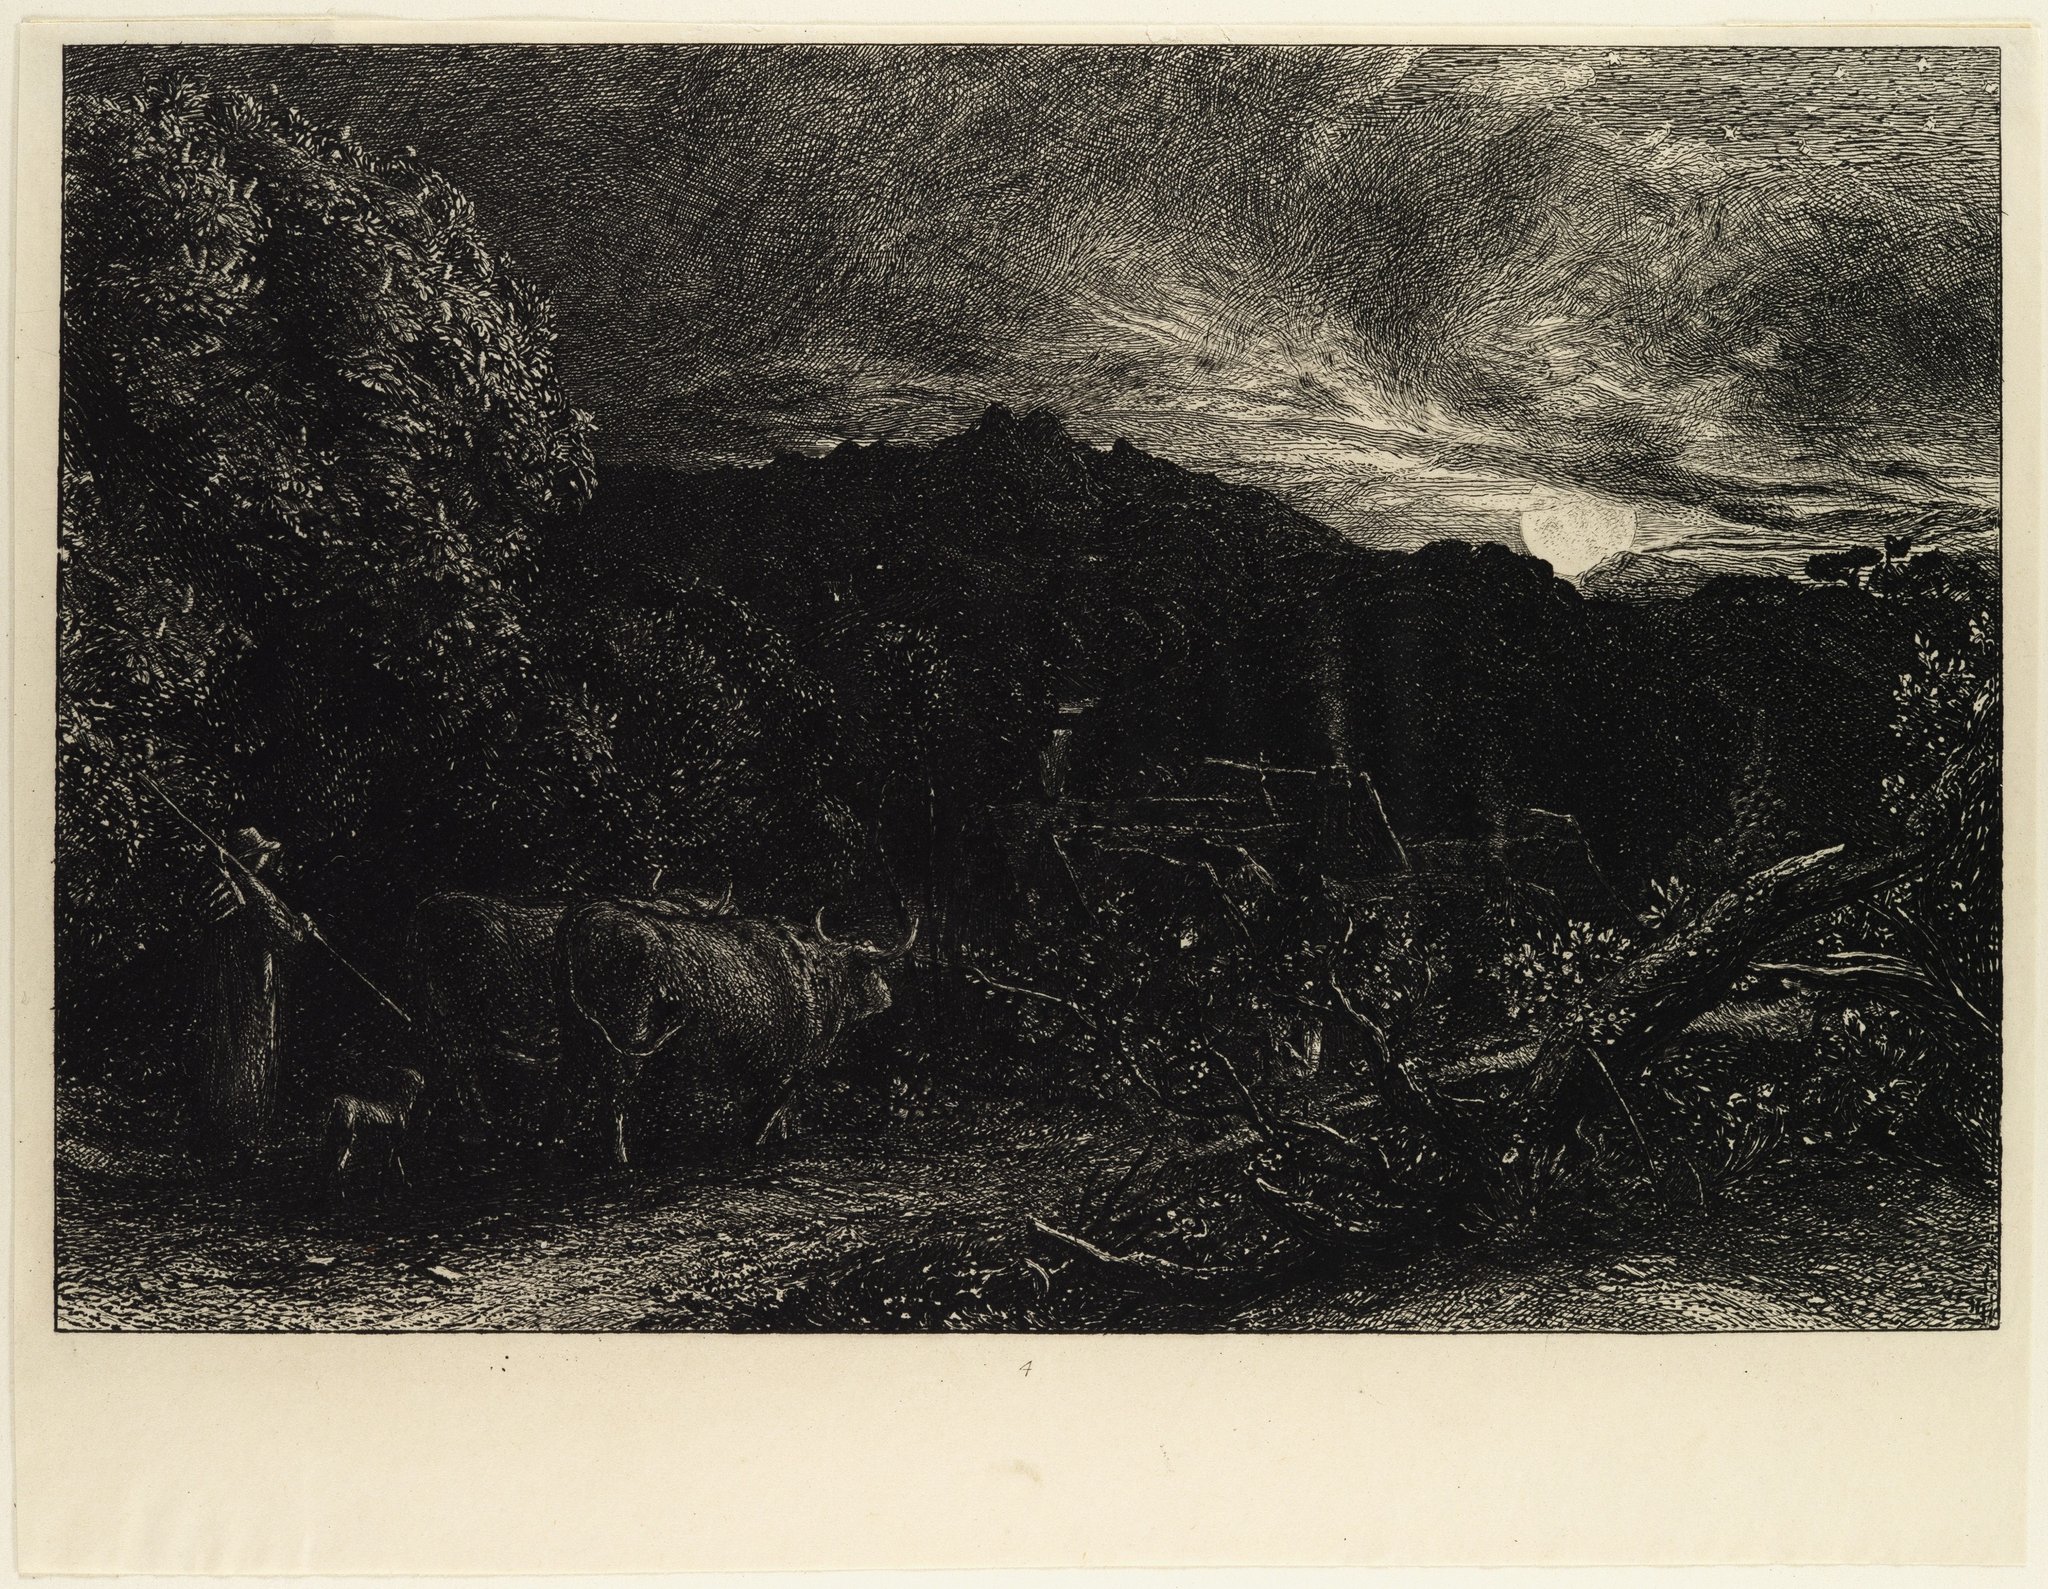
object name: print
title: The Weary Ploughman, or The Herdsman, or Tardus Bubulcus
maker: samuel palmer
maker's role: artist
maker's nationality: british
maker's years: 1805-1881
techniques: etching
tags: men,cows,moon,trees